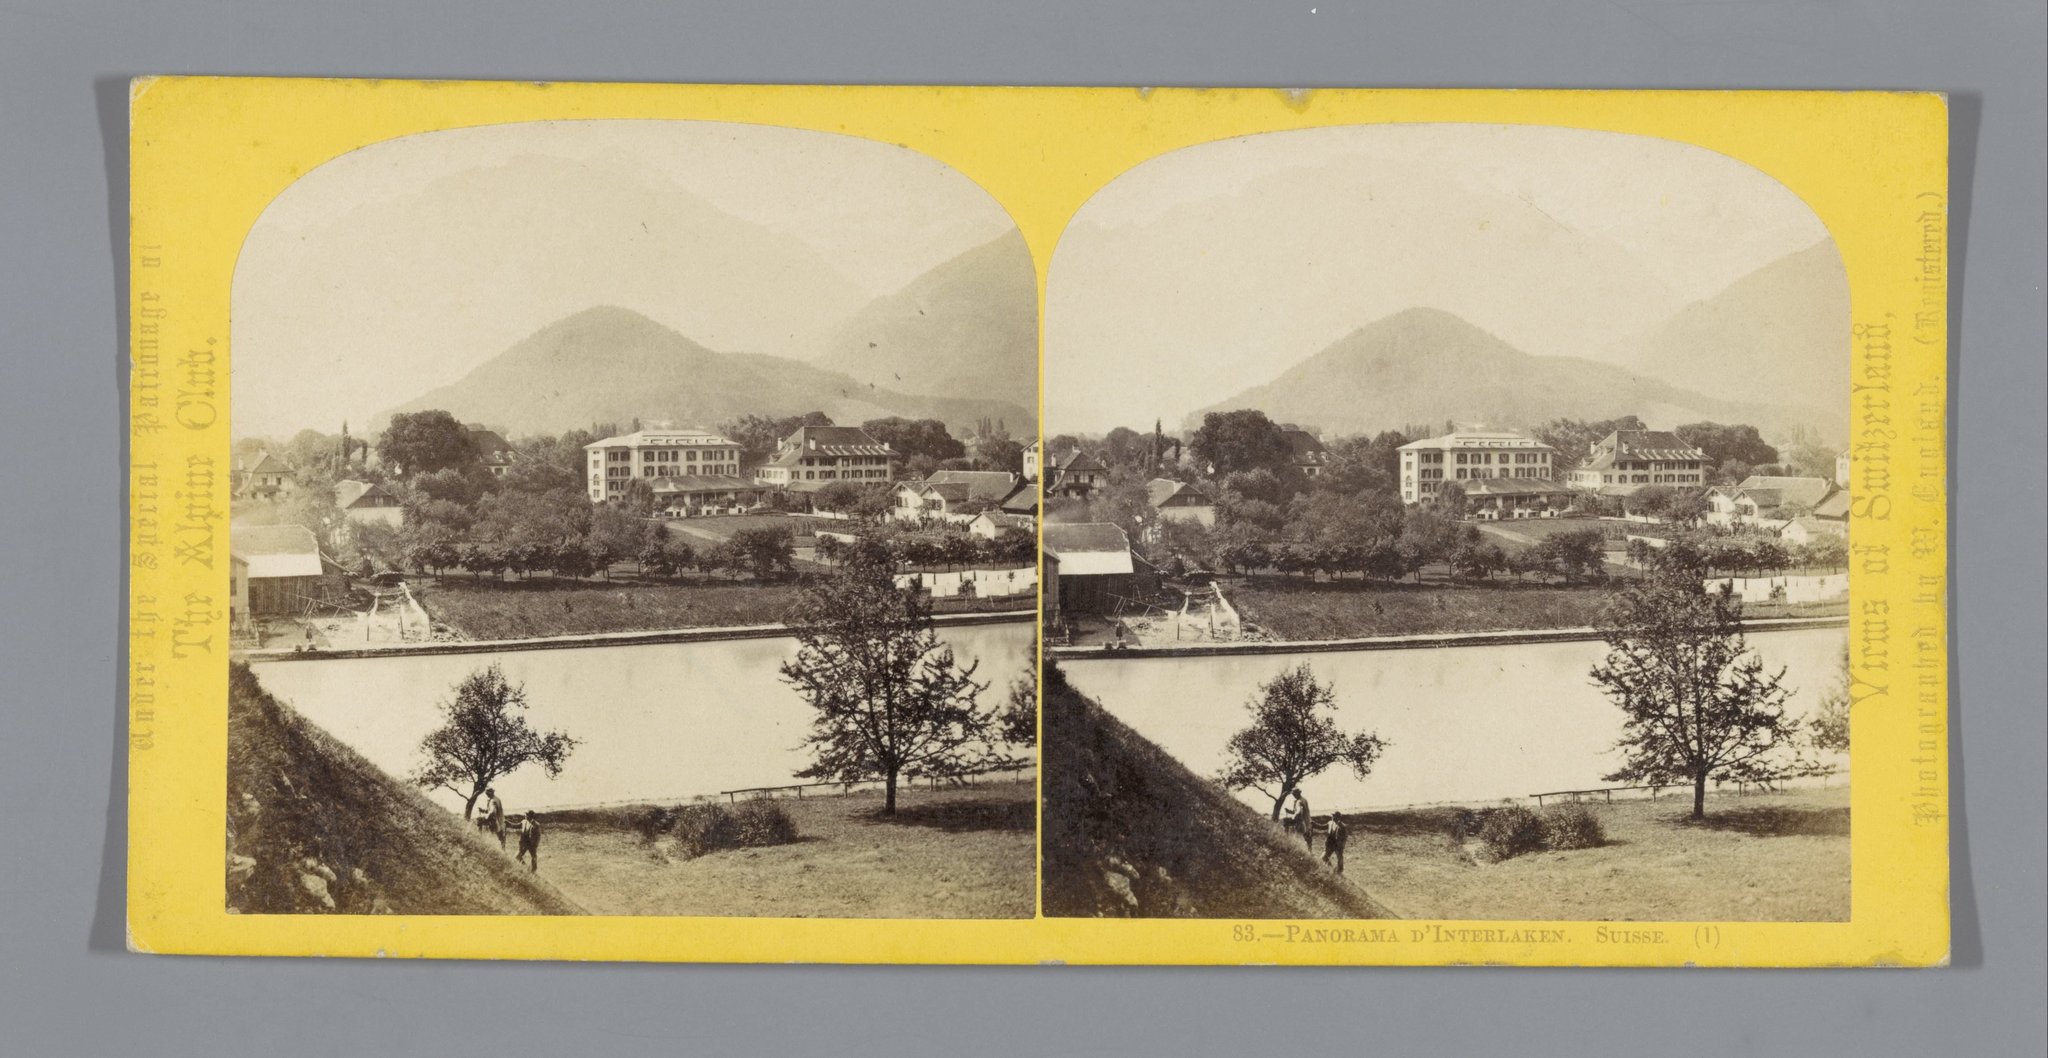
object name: stereograph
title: Panorama d'Interlaken. Suisse. (1)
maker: william england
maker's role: fotograaf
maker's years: 1816-1896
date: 1850-1880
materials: cardboard, photographic support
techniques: albumen print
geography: bern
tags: city-view in general; 'veduta', mountains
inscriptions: inscription: ‘Views of Switzerland, photographed by W. England. (Registered) Under the Special Patronage of the Alpine Club.’, number: ‘83.’